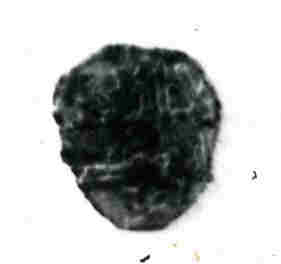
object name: coin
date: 701-900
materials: copper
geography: iran